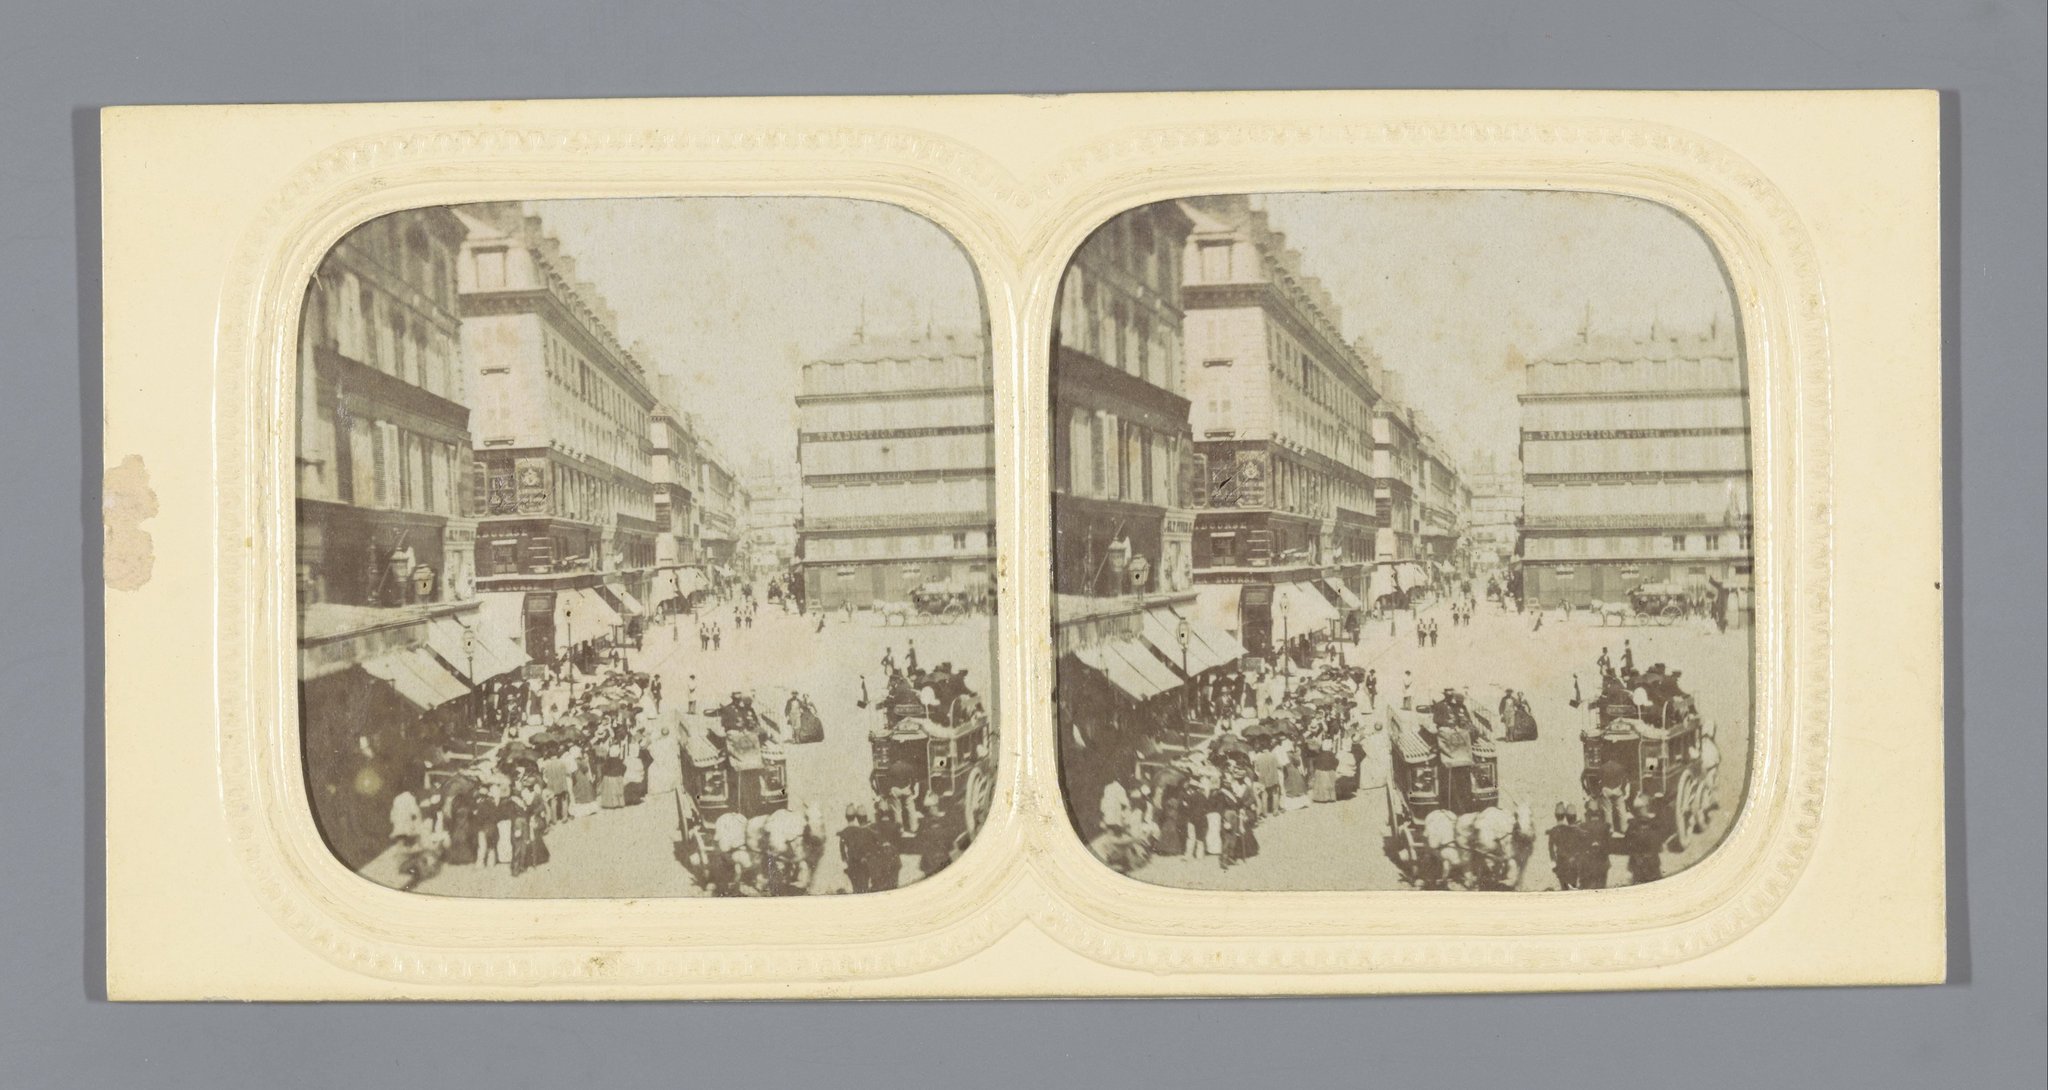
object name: tissue stereograph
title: Straatbeeld in Parijs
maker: Anonymous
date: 1855-1875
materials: cardboard, paper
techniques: albumen print, cutting, hand coloring, perforating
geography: paris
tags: street, paris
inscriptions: number: ‘50’